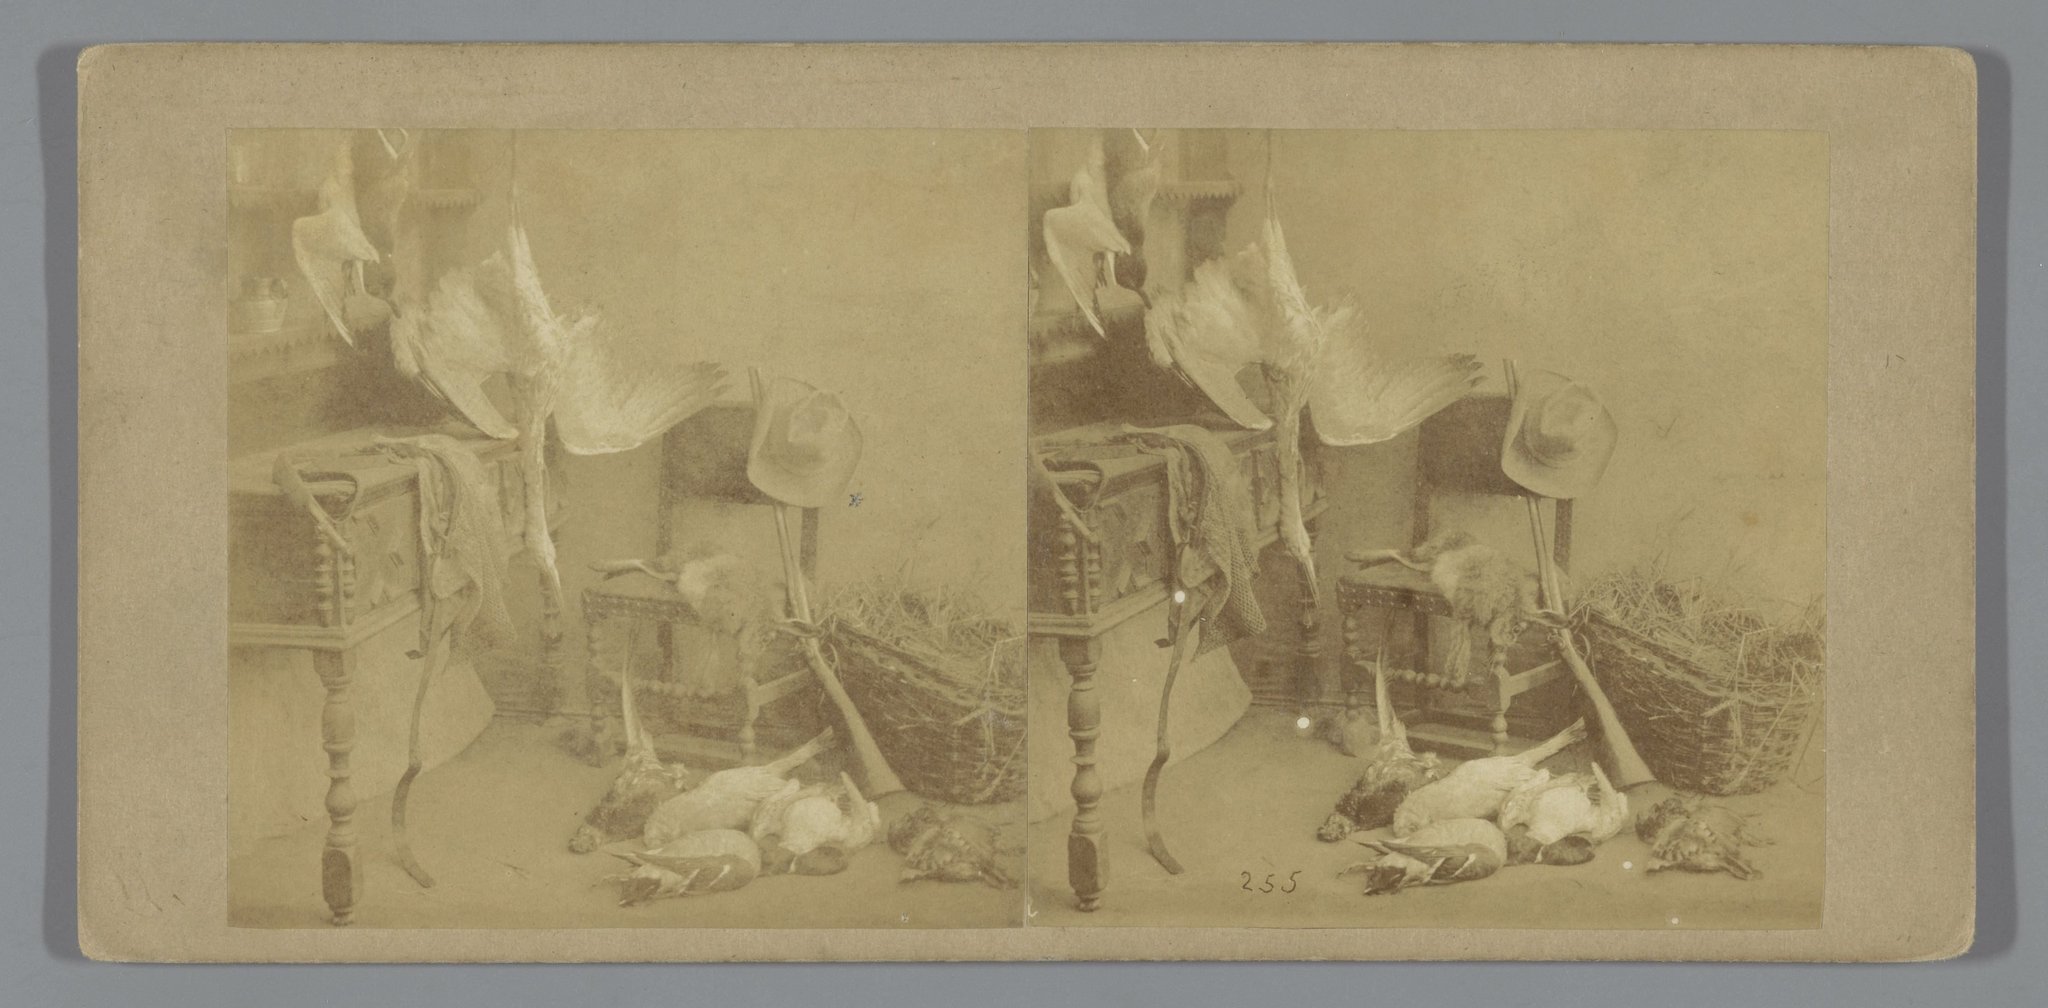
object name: stereograph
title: Stilleven met jachtattributen en geschoten wild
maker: Anonymous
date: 1855-1870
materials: cardboard, photographic support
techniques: albumen print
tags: game, hunted animals, still life of miscellaneous objects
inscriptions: number: ‘255’, number: ‘19’, number: ‘94’, : ‘Anna Carel Hening Fam. Hening’